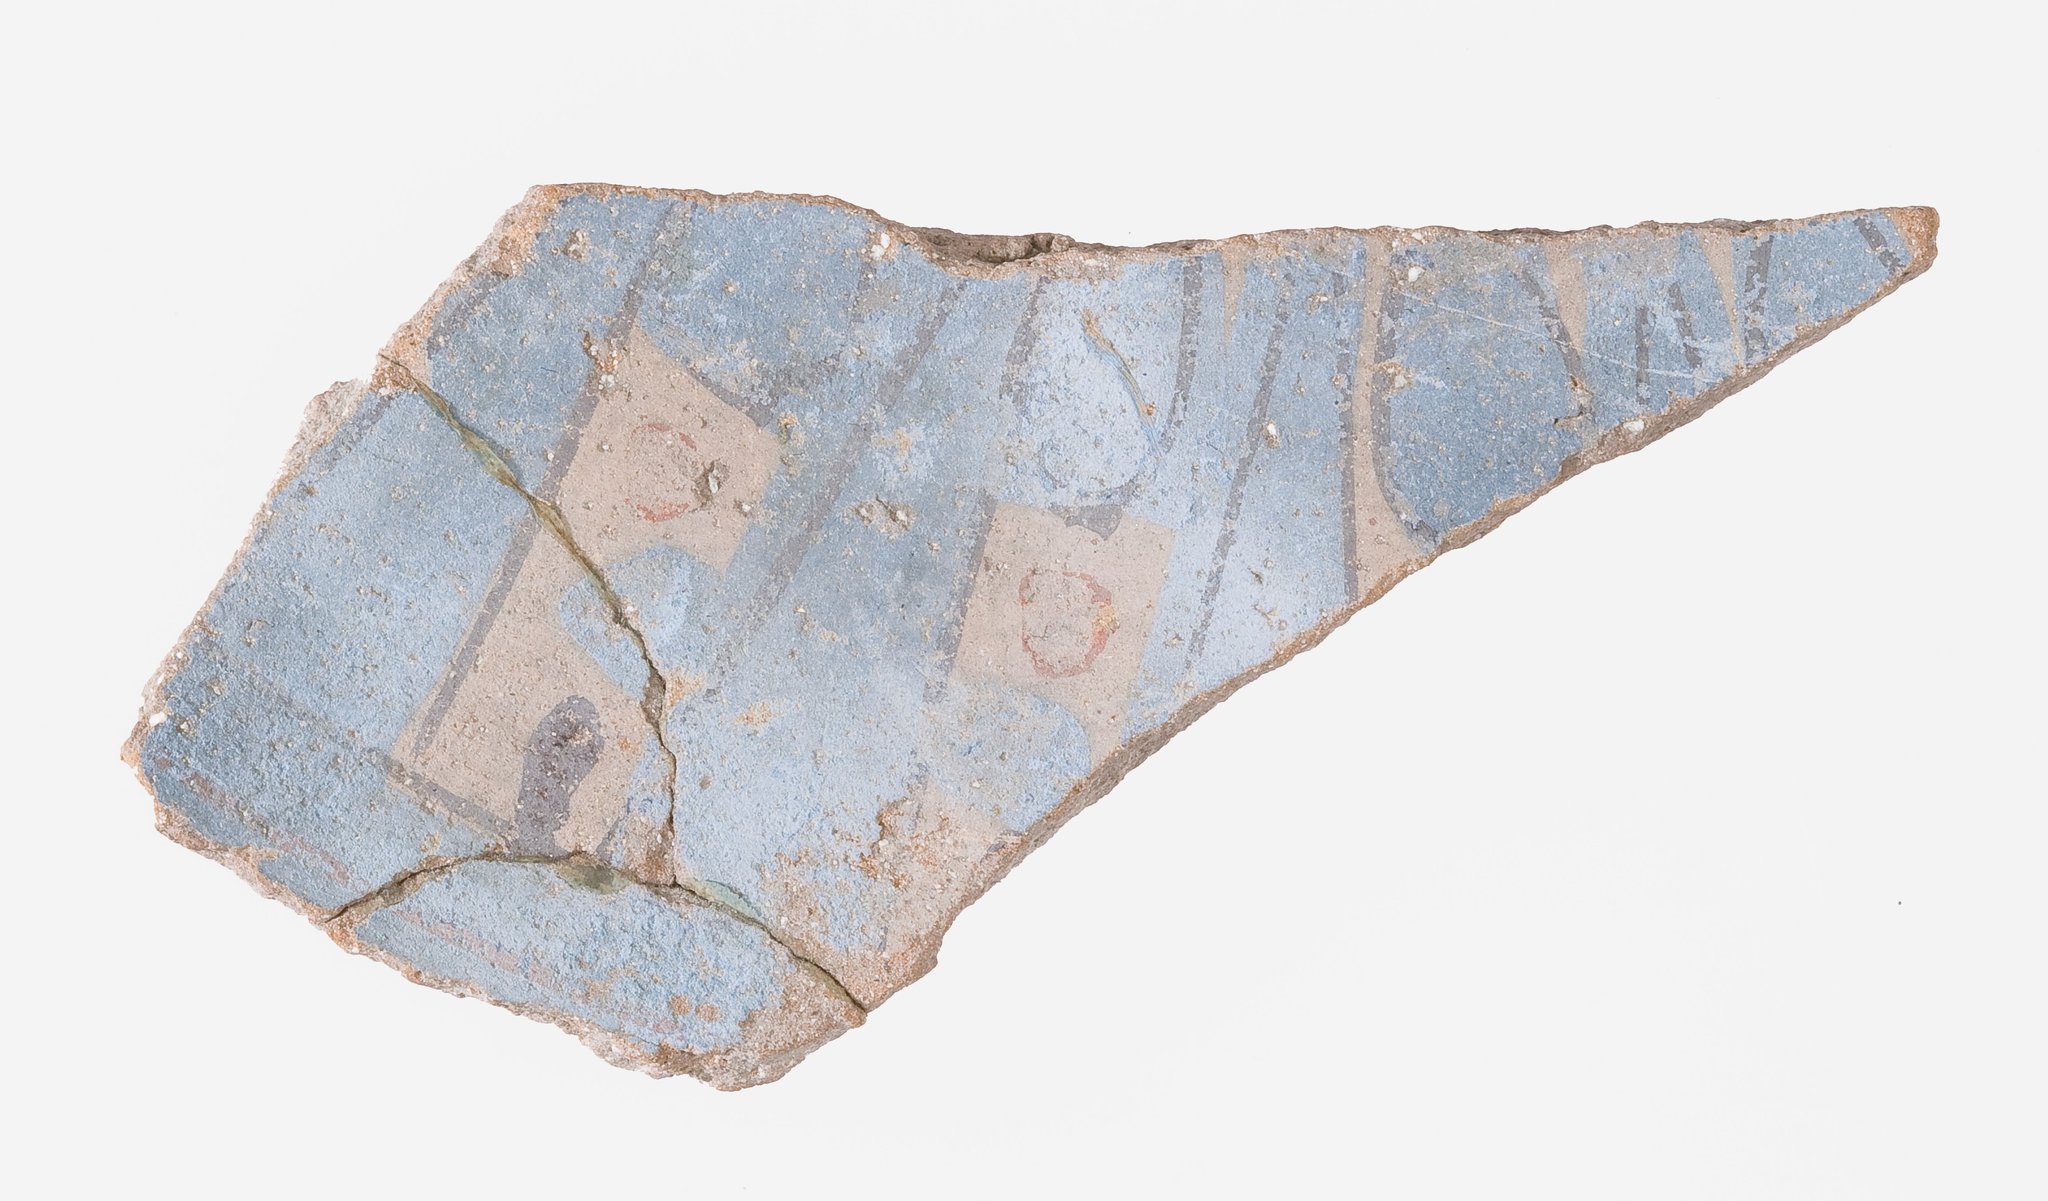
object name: vessel fragment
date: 1390-1352 BCE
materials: paint, pottery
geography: egypt